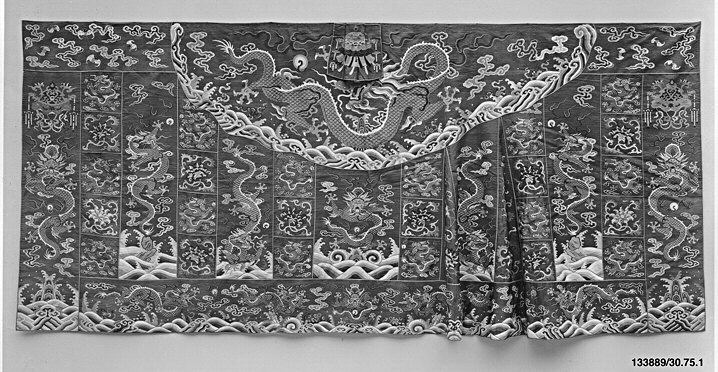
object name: robe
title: Robe for Buddhist Priest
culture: chinese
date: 1701-1800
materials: metal thread, silk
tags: dragons